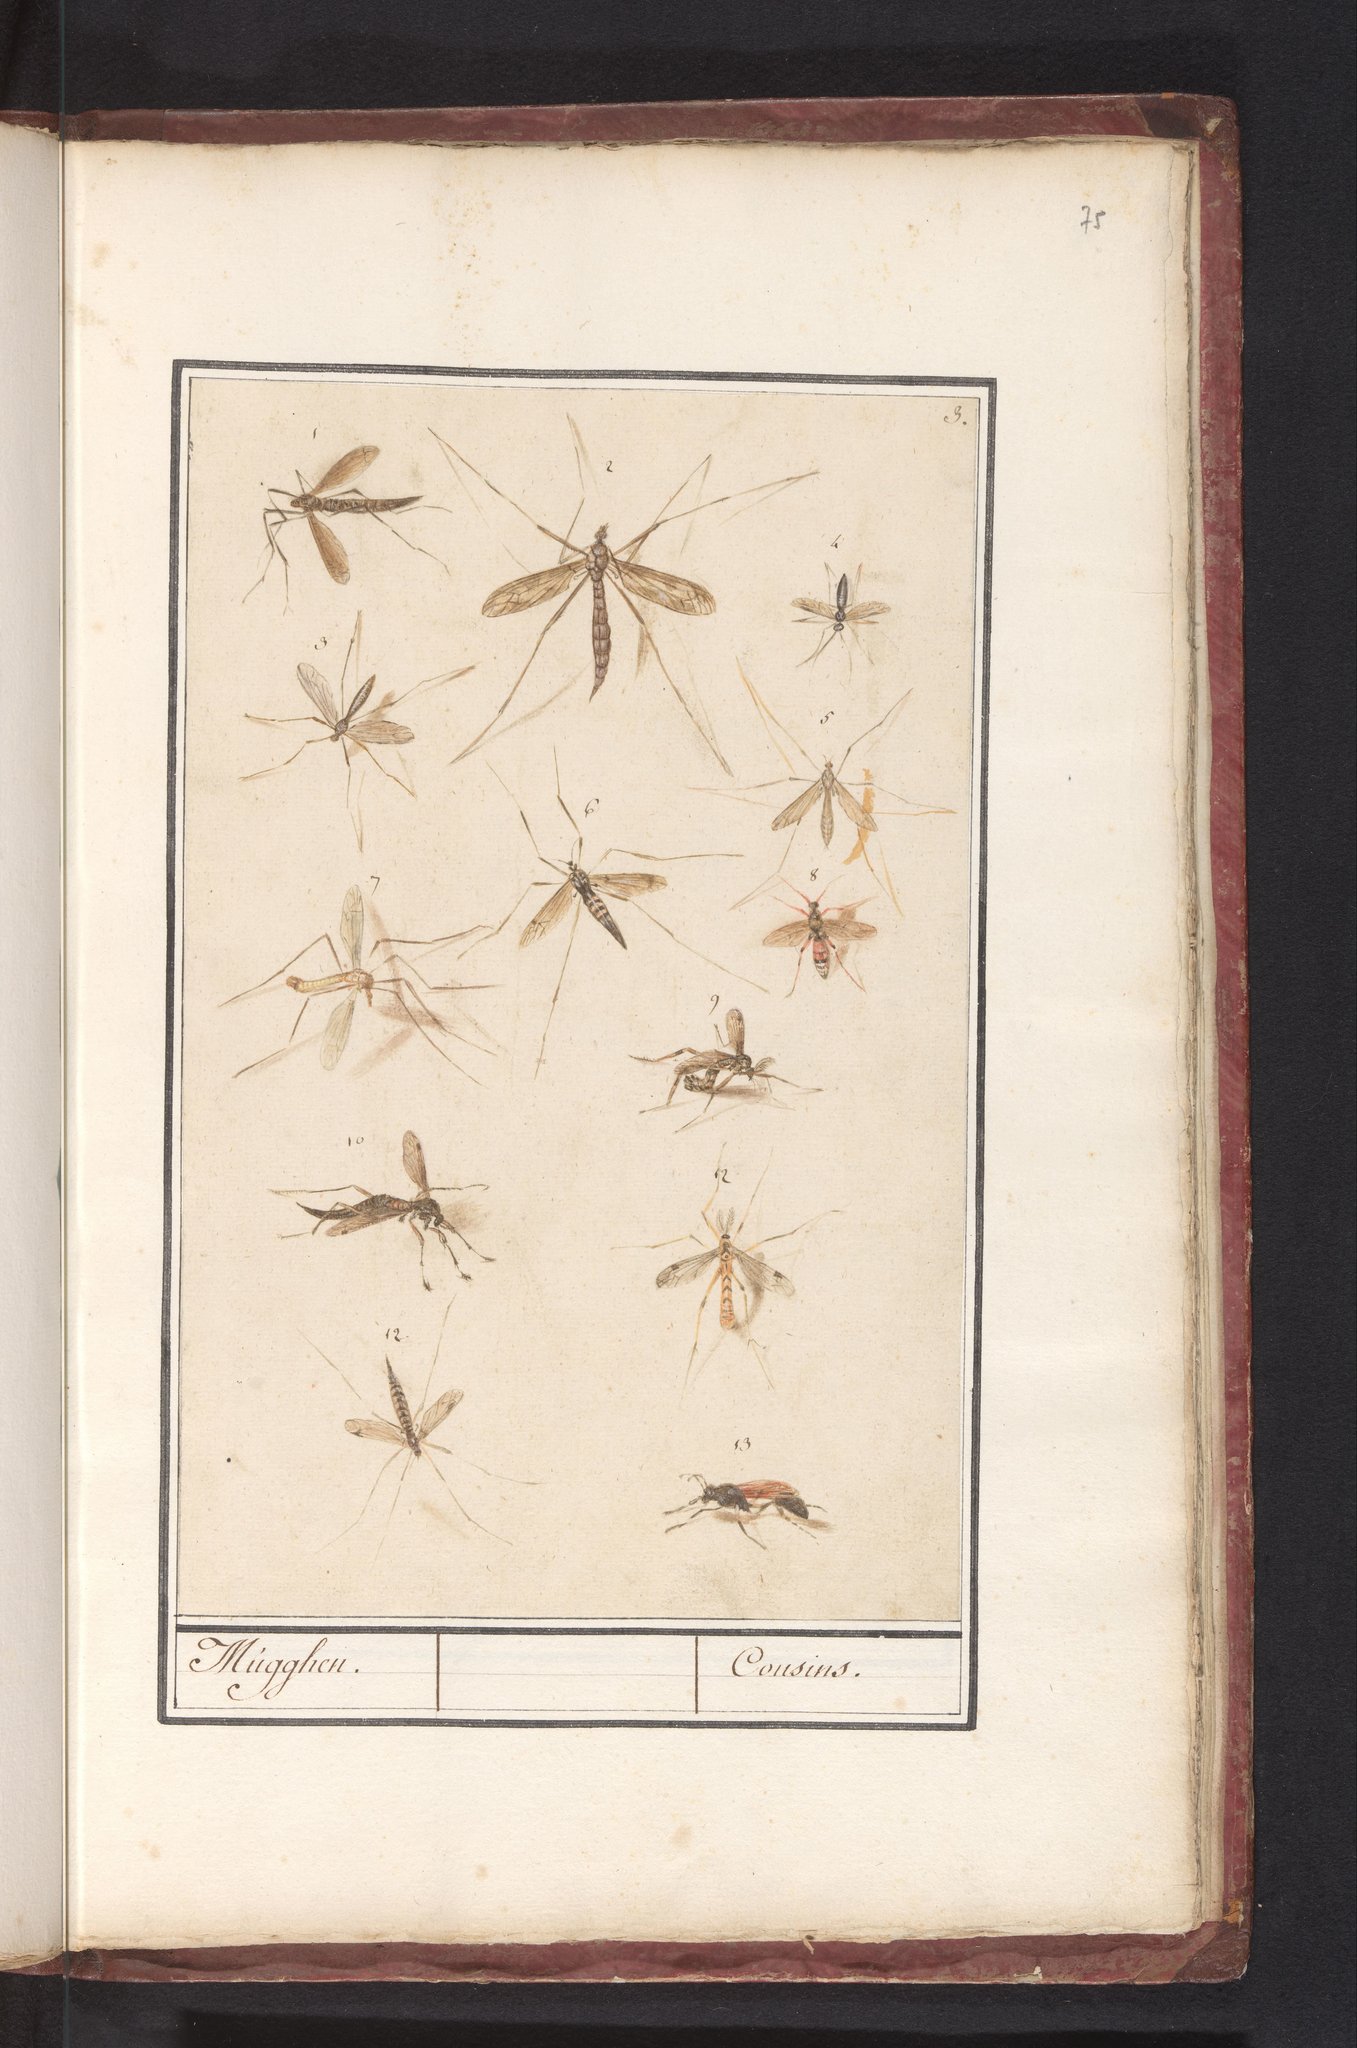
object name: drawing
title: Leaf with thirteen mosquitoes (Rudolf II’s Historia Naturalis)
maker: anselmus boëtius de boodt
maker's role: draughtsman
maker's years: 1550-1632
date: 1596-1610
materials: chalk, paint, ink, paper, pencil, watercolor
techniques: brush, pen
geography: prague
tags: insects: crane fly, insects: wasp, insects: mosquito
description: Anselmus de Boodt was court physician to Emperor Rudolf II in Prague. Scientific interest in natural phenomena ran high at his court. There, De Boodt produced his Historia Naturalis, a series of albums with hundreds of images of animals and plants. This sheet of ordinary mosquitoes bears witness fo his exceptional powers of observation. Each of the thirteen mosquitoes is slightly different.